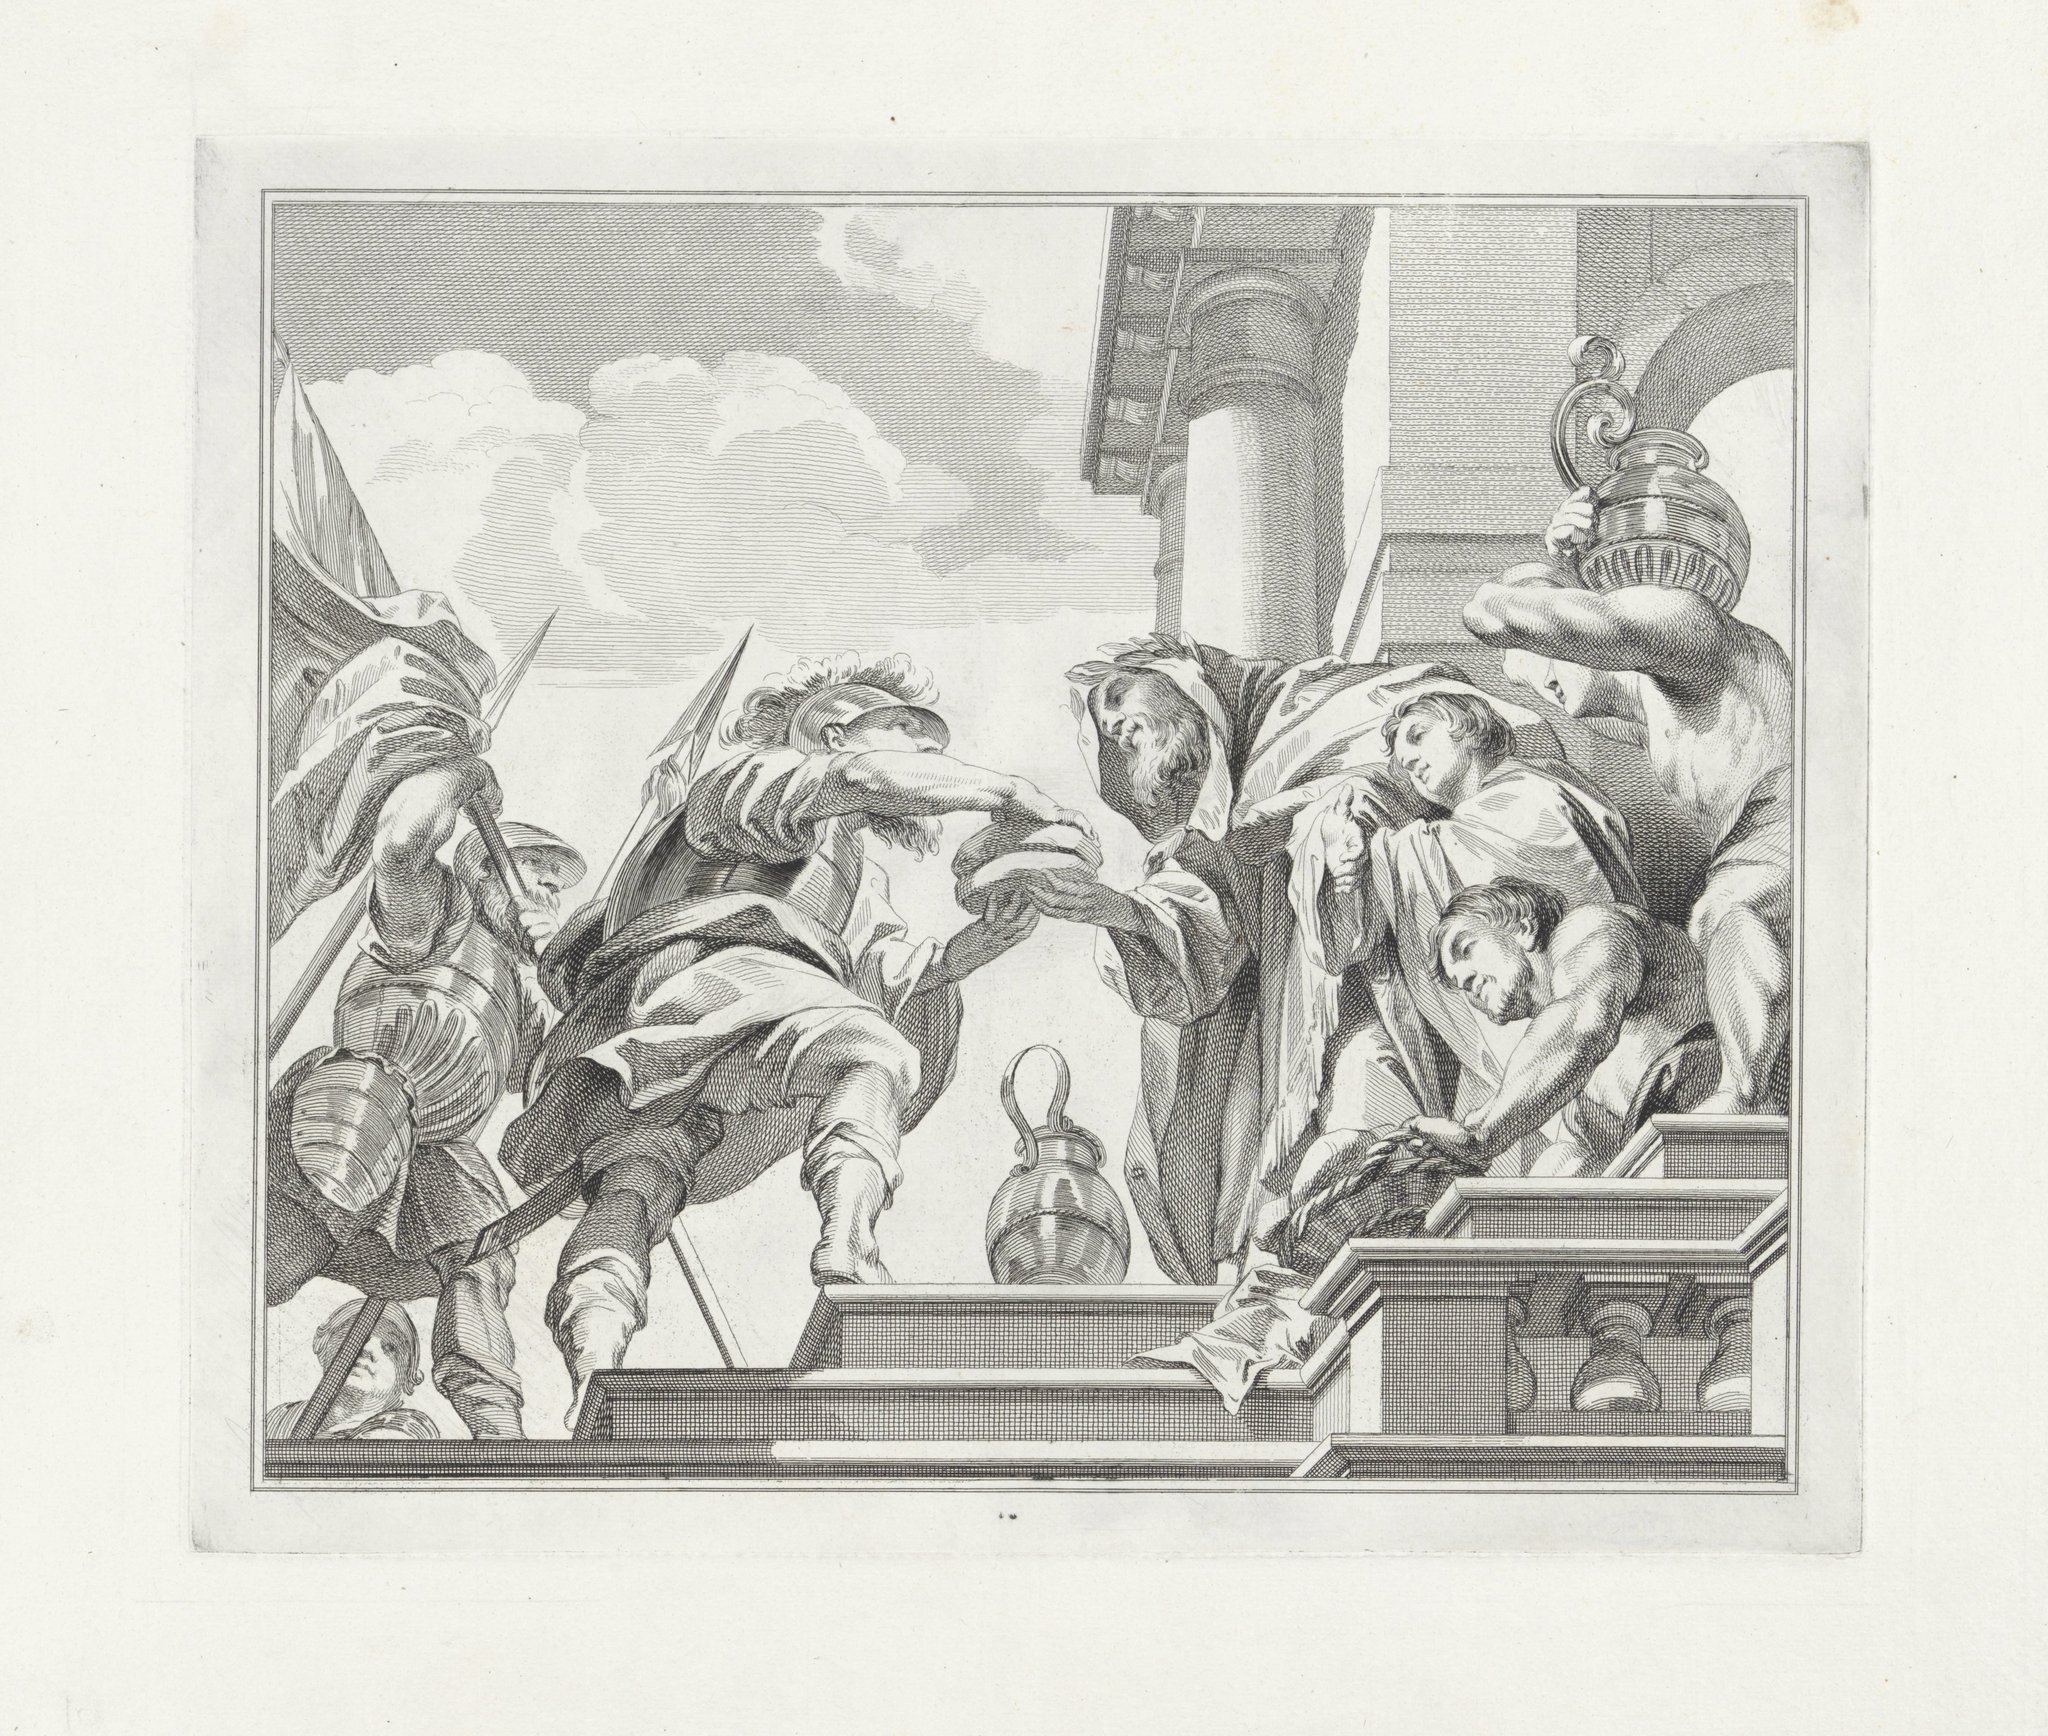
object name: print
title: Les plat-fonds ou les tableaux des galeries / De plafonds of gallerystukken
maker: jan punt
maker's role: draughtsman, print maker, publisher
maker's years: 1711-1779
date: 1751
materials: paper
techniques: engraving, etching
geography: amsterdam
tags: the meeting of abraham and melchizedek, the high priest and king of salem, who brings bread and wine (genesis 14:18-20)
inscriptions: collector's mark: Lugt 2228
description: Melchisedek staat op een trap en overhandigt twee broden aan Abraham.